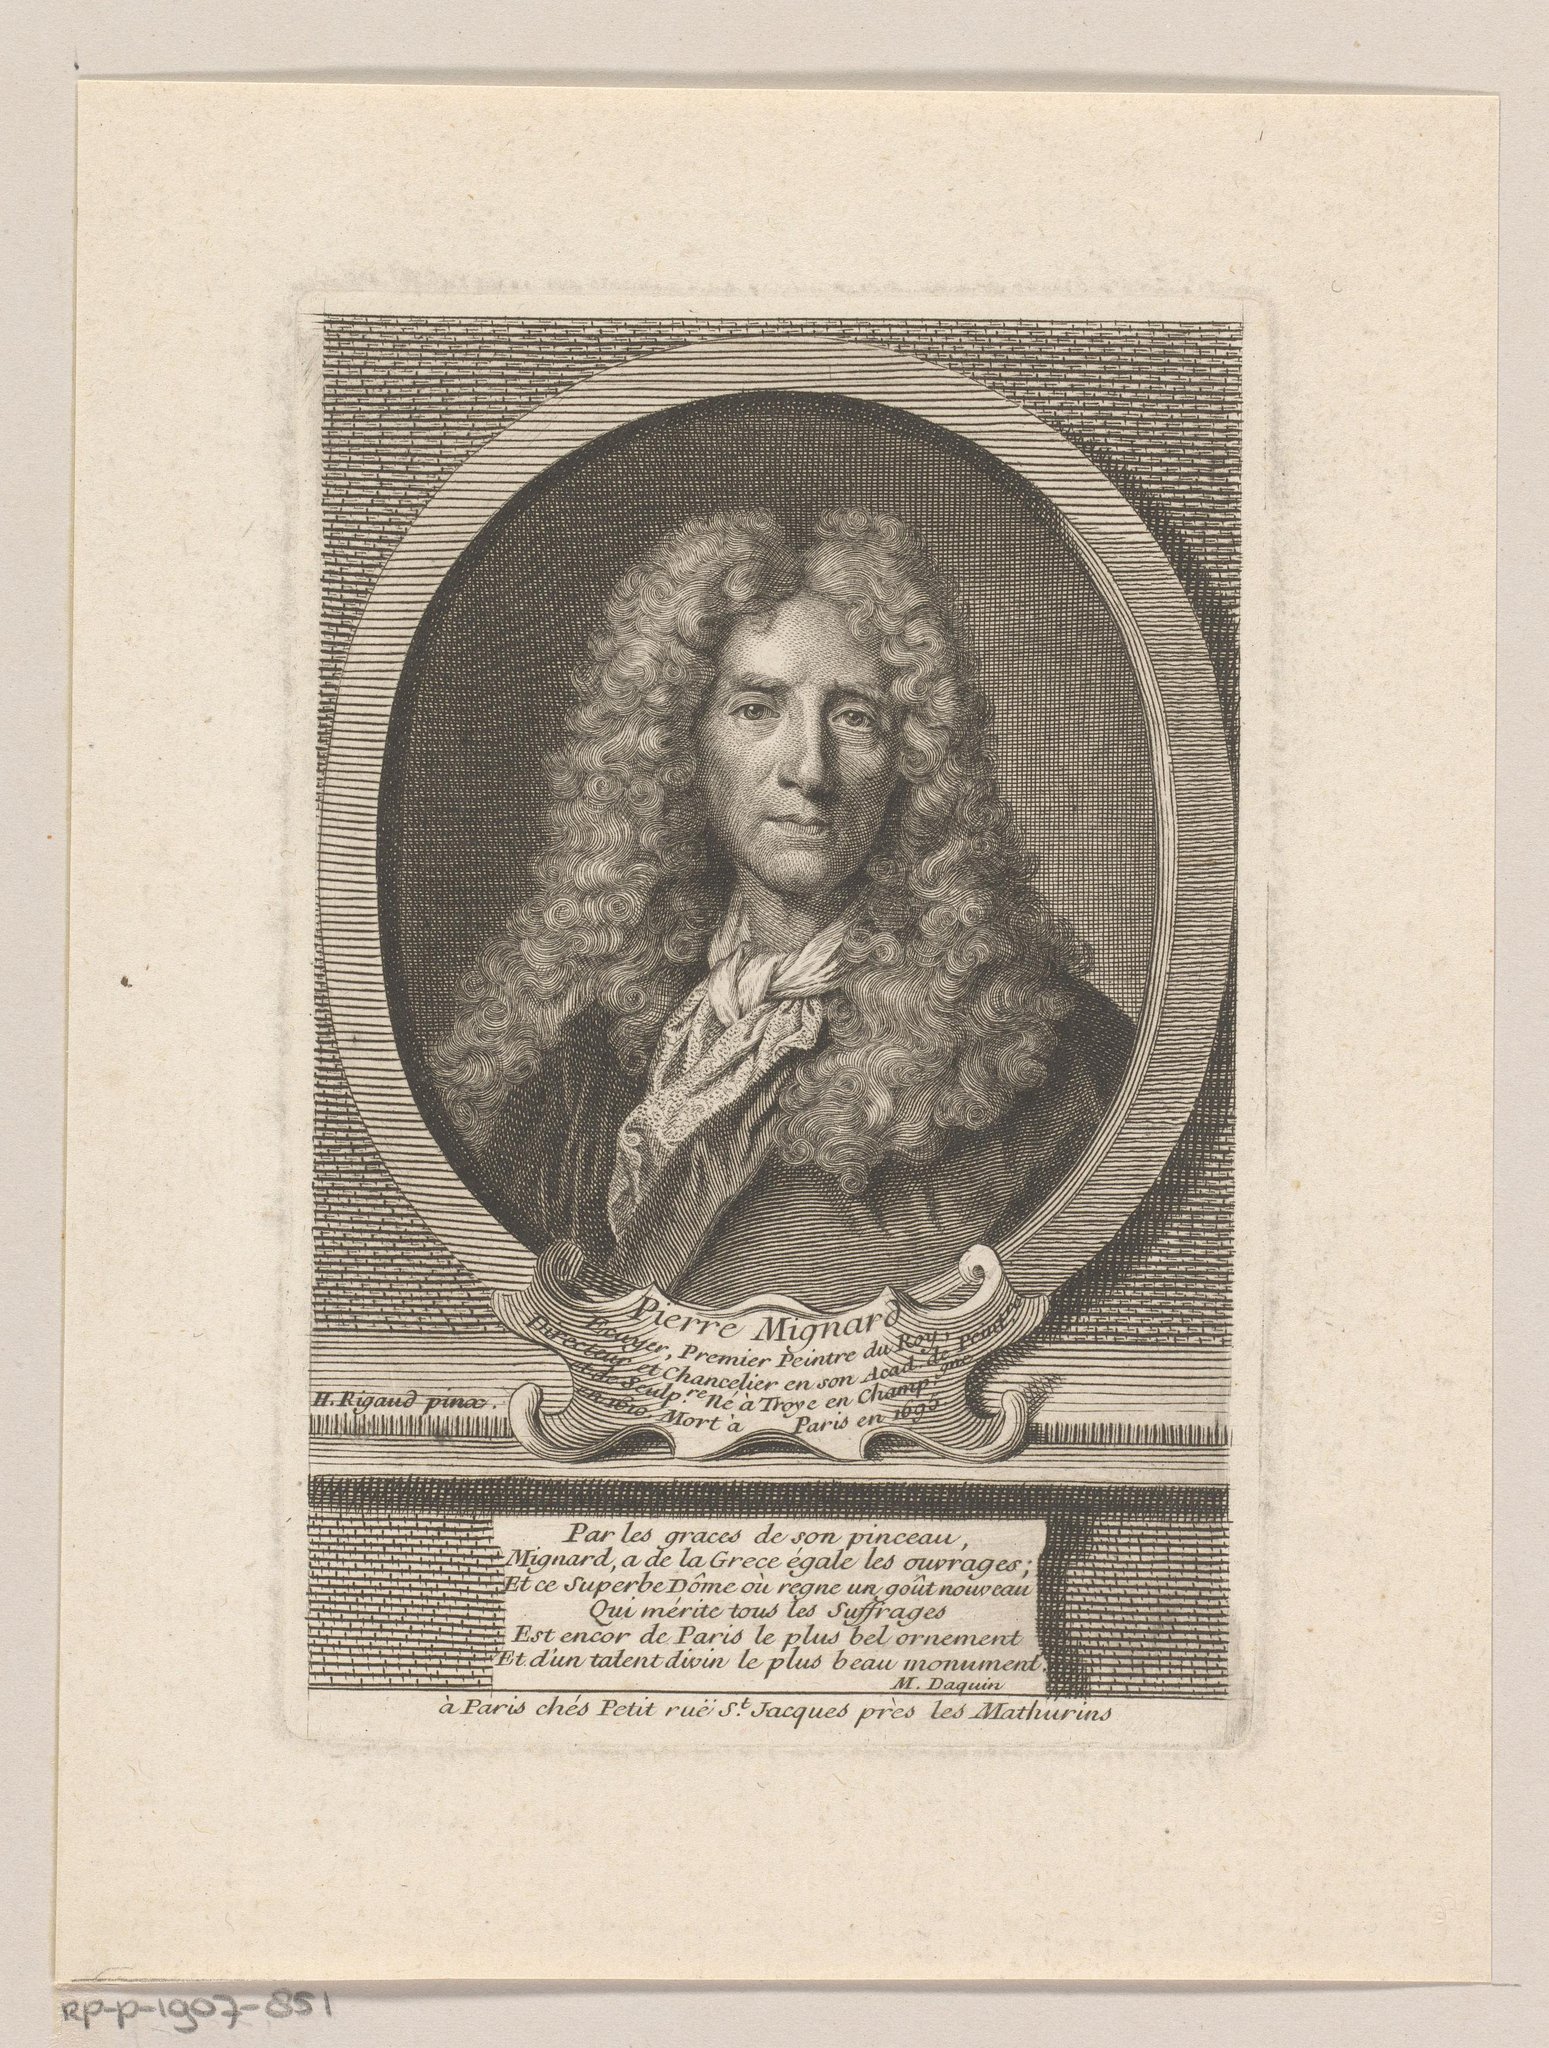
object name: print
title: Pierre Mignard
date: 1695-1850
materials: paper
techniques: engraving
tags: paris, draughtsman, pierre mignard (1612-1695), historical persons, portrait, self-portrait of painter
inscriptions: collector's mark: Lugt 2228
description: Met tienregelig onderschrift in het Frans.